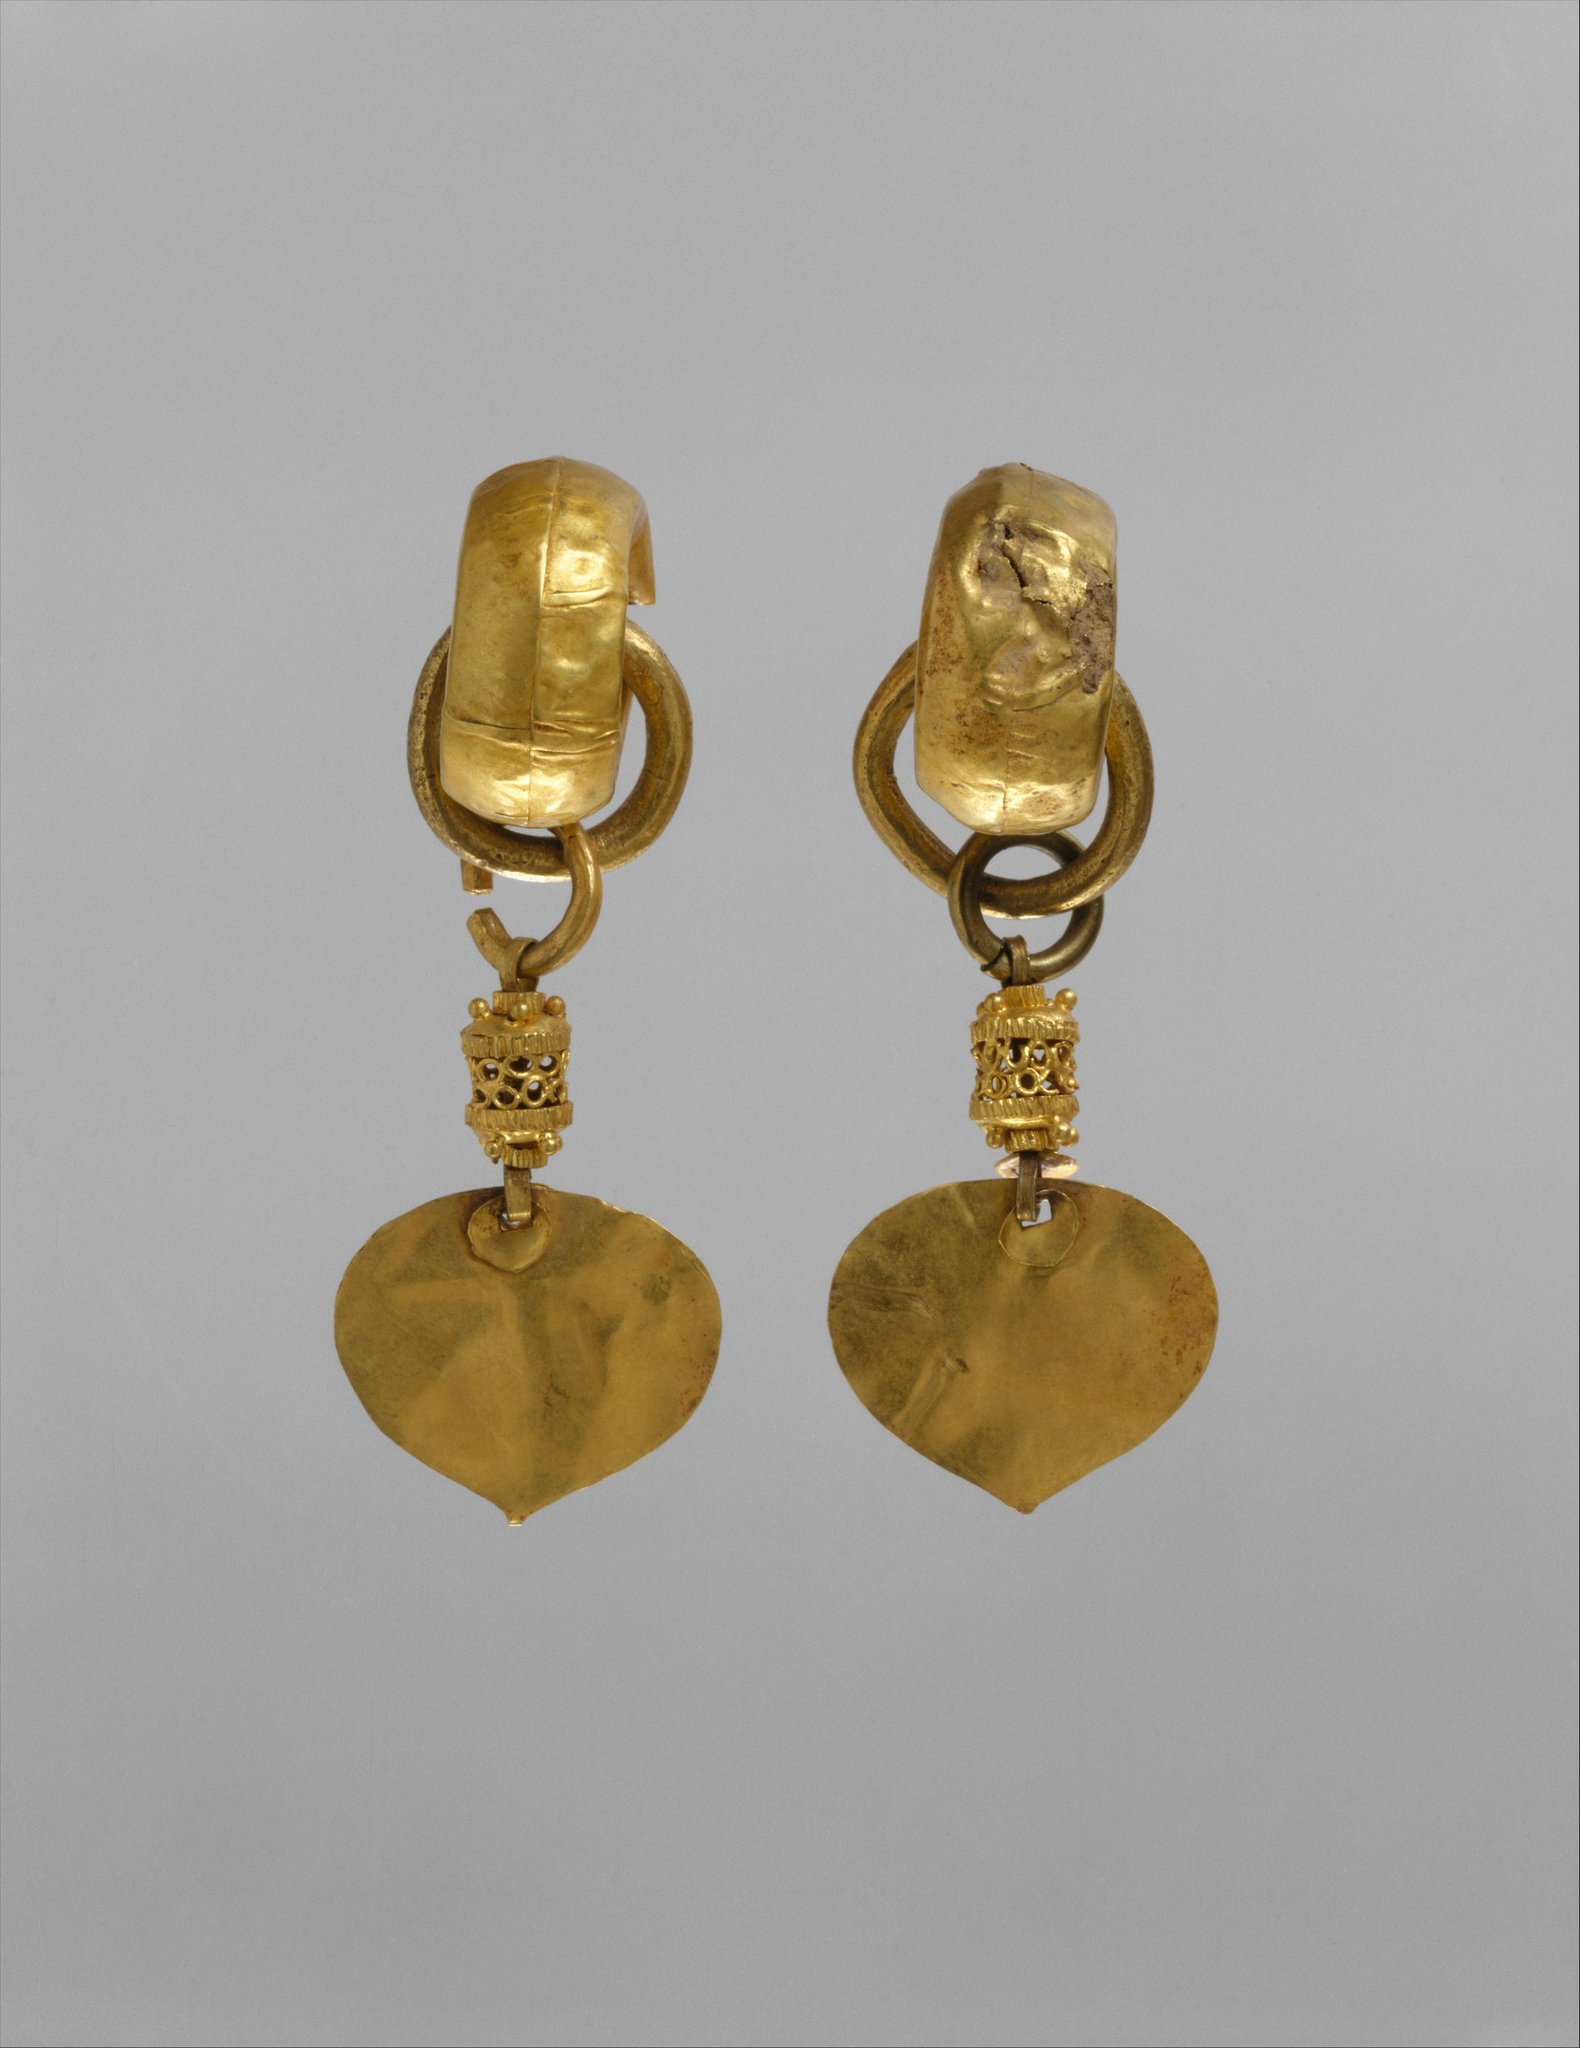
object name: earring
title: Earring (one of a pair)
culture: korean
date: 401-500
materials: gold